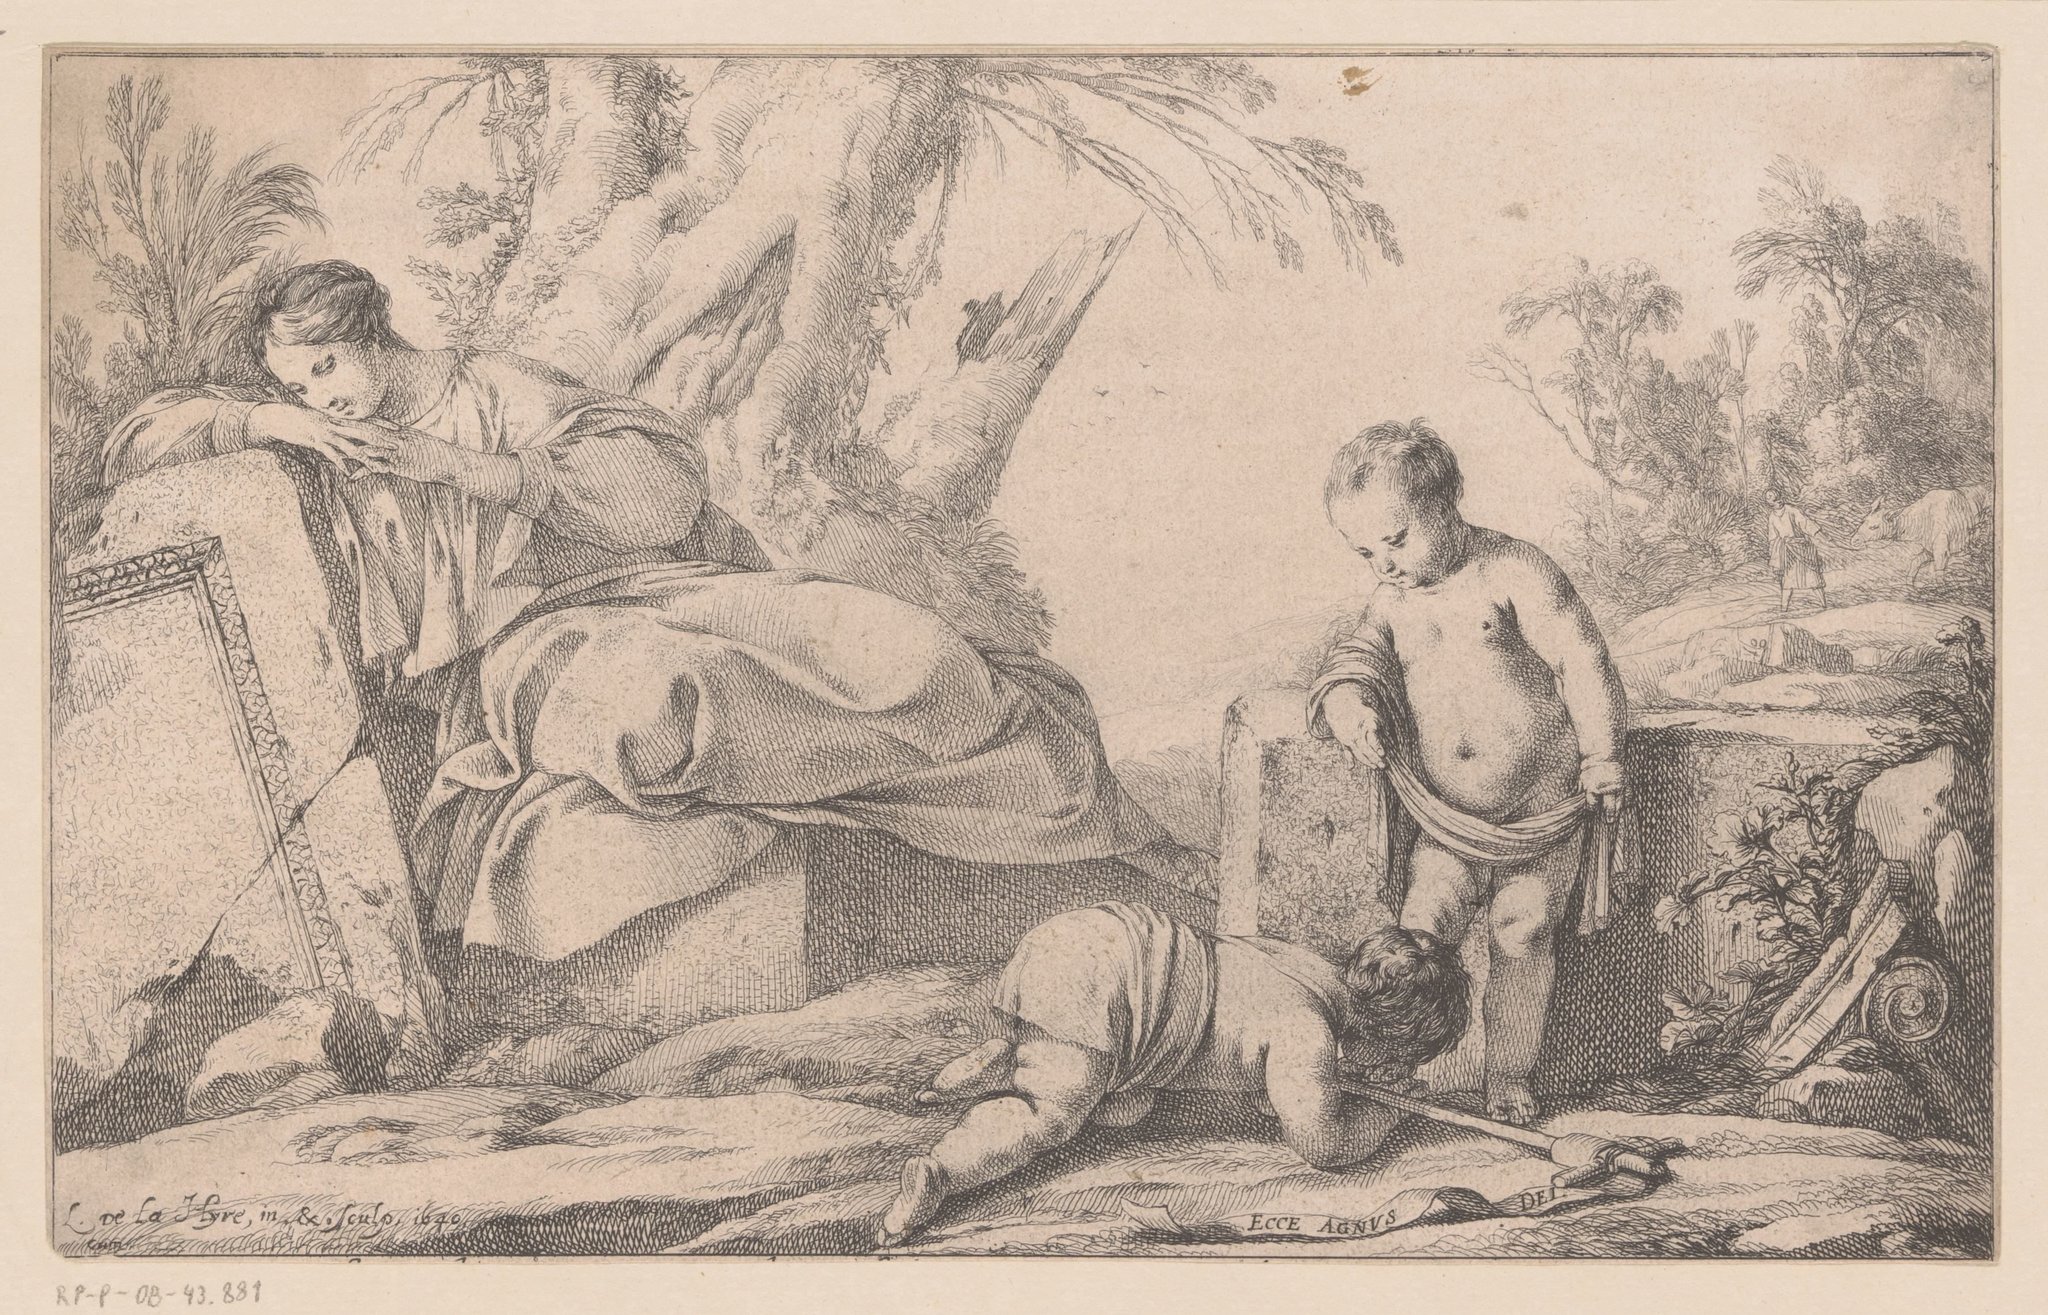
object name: print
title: Maria met Kind en Johannes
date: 1640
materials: paper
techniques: engraving, etching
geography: paris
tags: mary and the christ-child with john the baptist (as child)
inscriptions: collector's mark: Lugt 2228